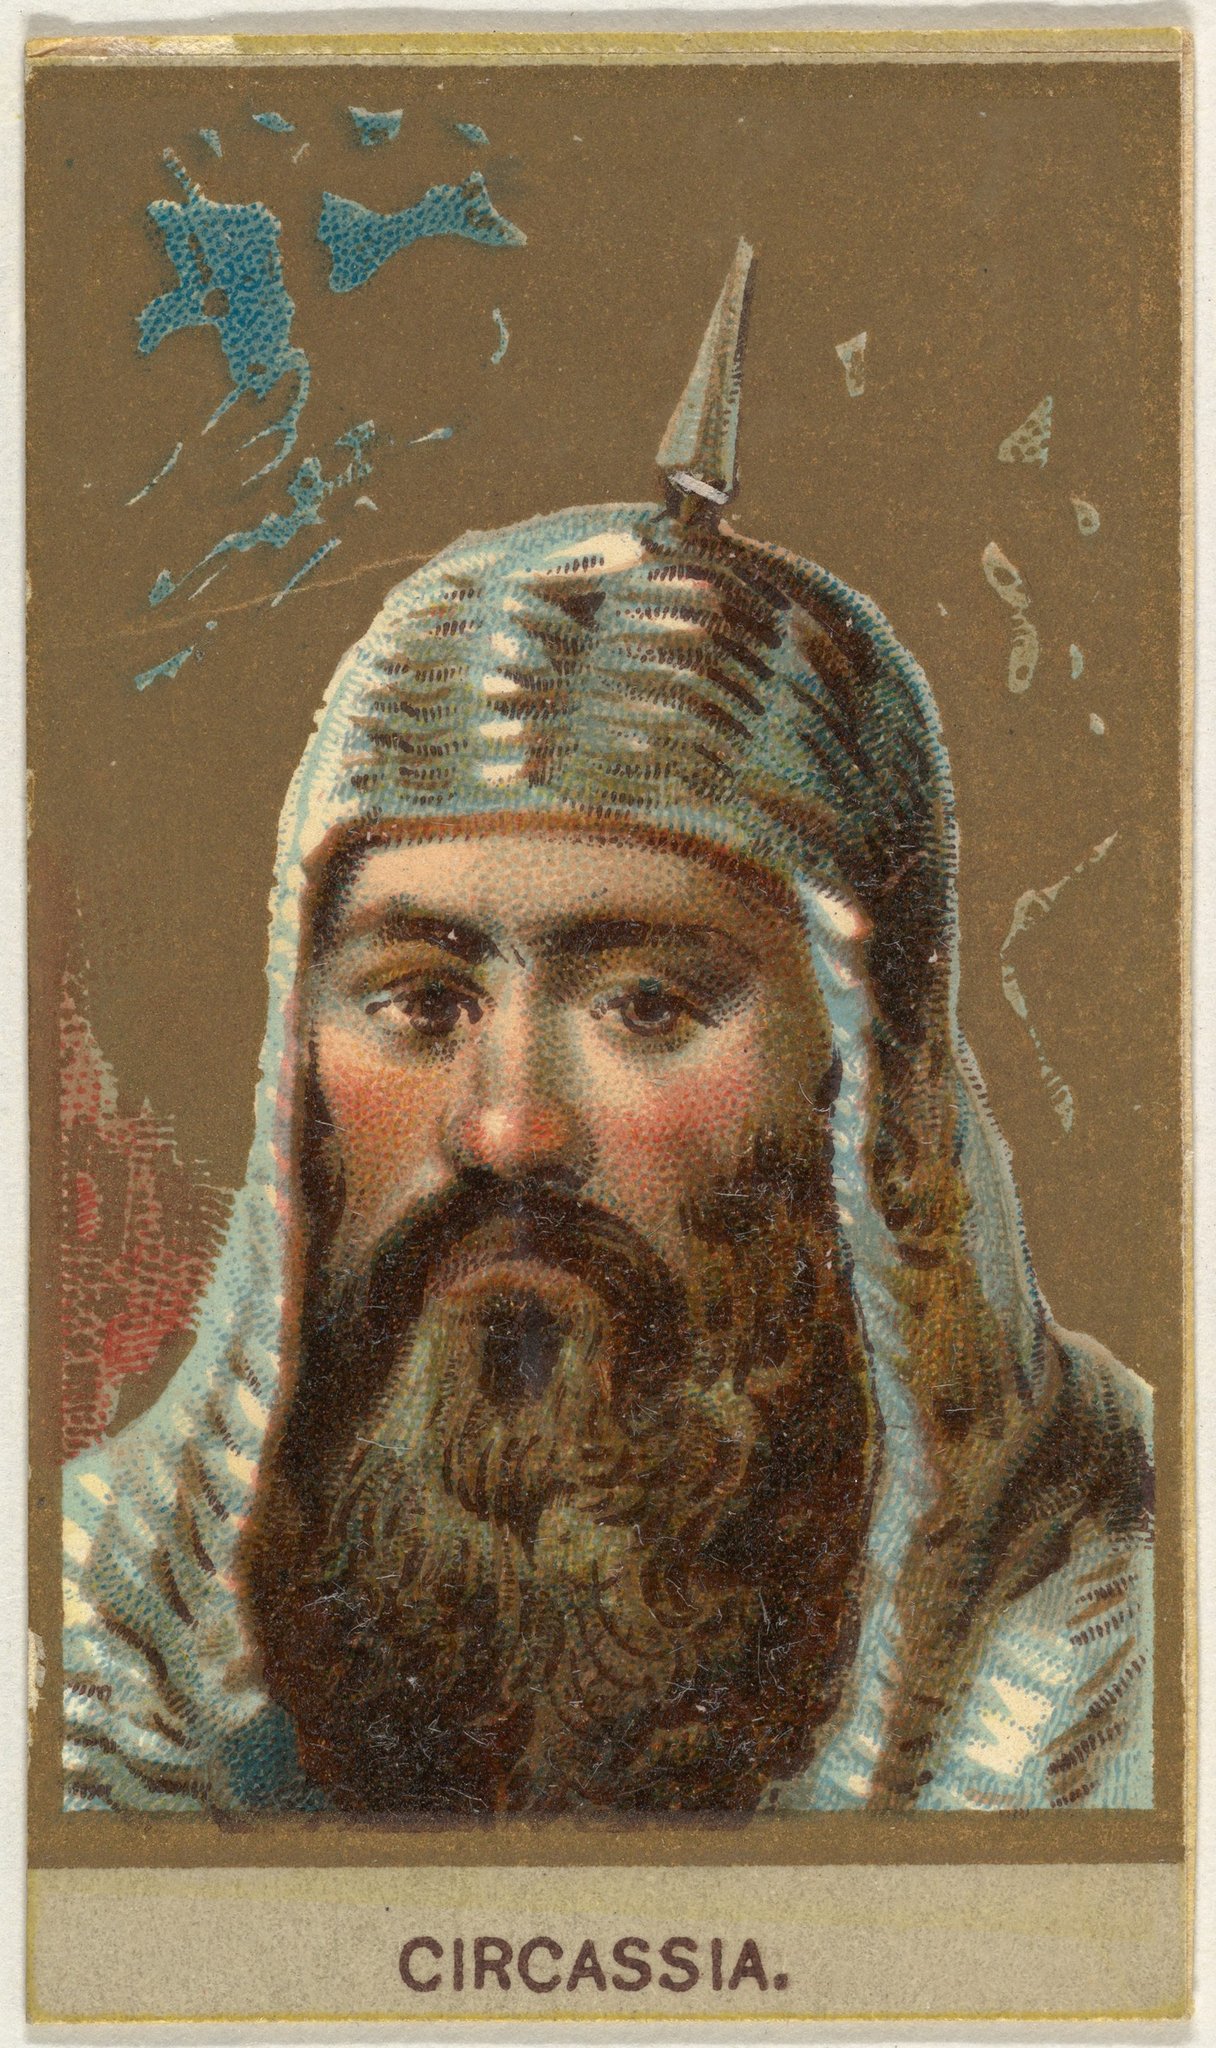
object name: print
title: Circassia, from the Races of Mankind series (T181) issued by Abdul Cigarettes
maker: abdul cigarettes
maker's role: publisher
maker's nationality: american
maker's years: 1881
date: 1881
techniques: color lithograph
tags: men